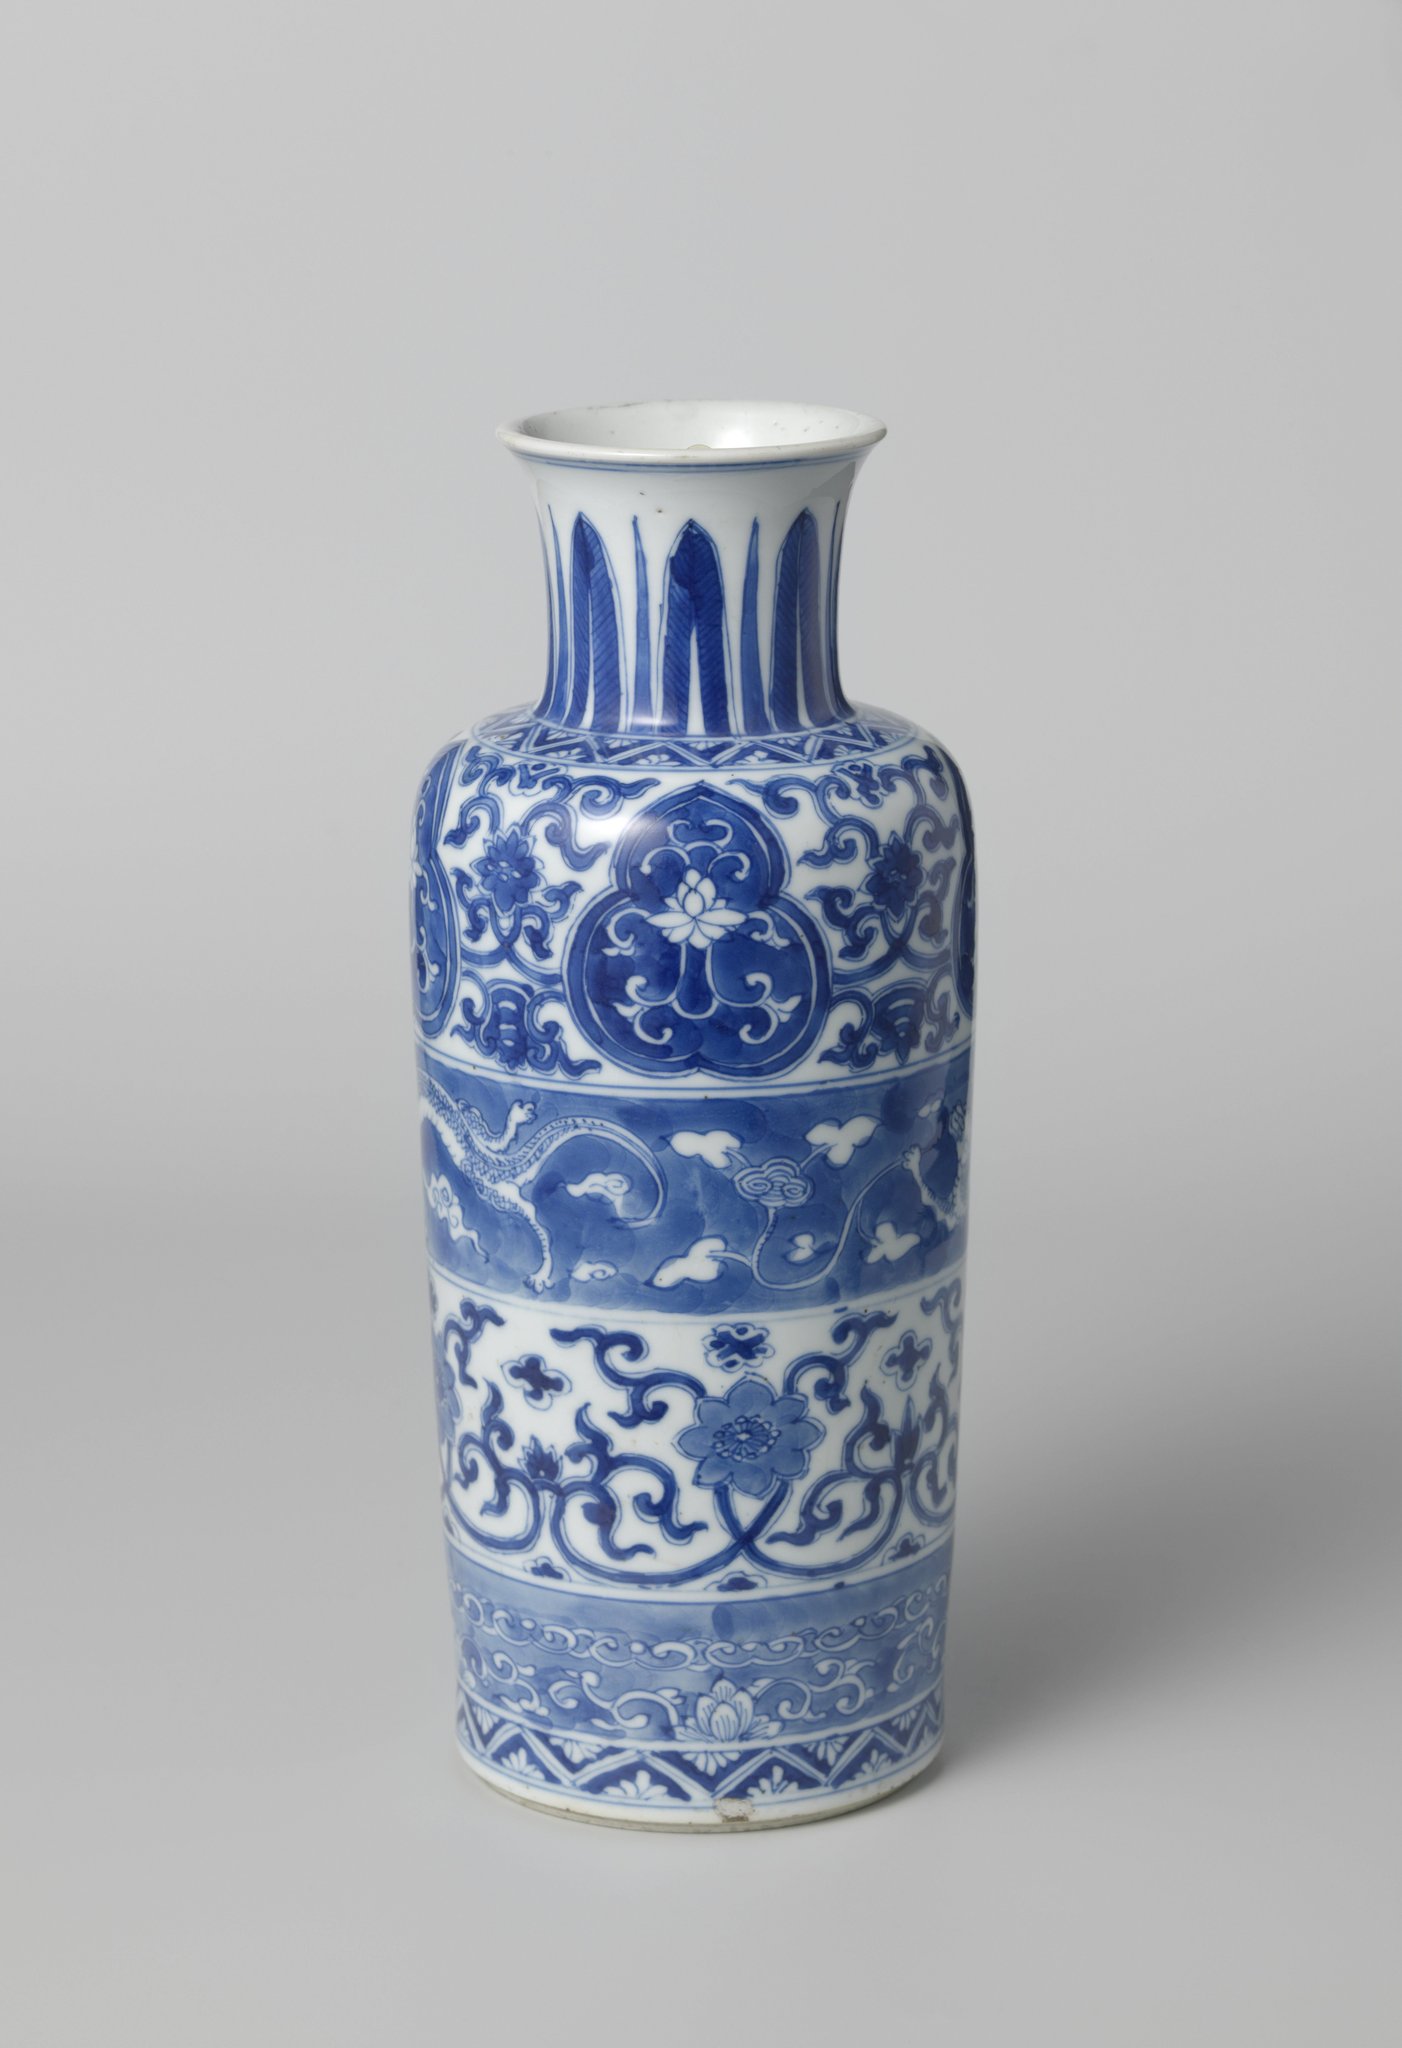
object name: rolwagen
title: Vase (rolwagen) with dragons and lotus and flower scrolls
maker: Anonymous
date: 1680-1720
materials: cobalt, glaze, paint, porcelain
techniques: firing, turning, vitrification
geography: china